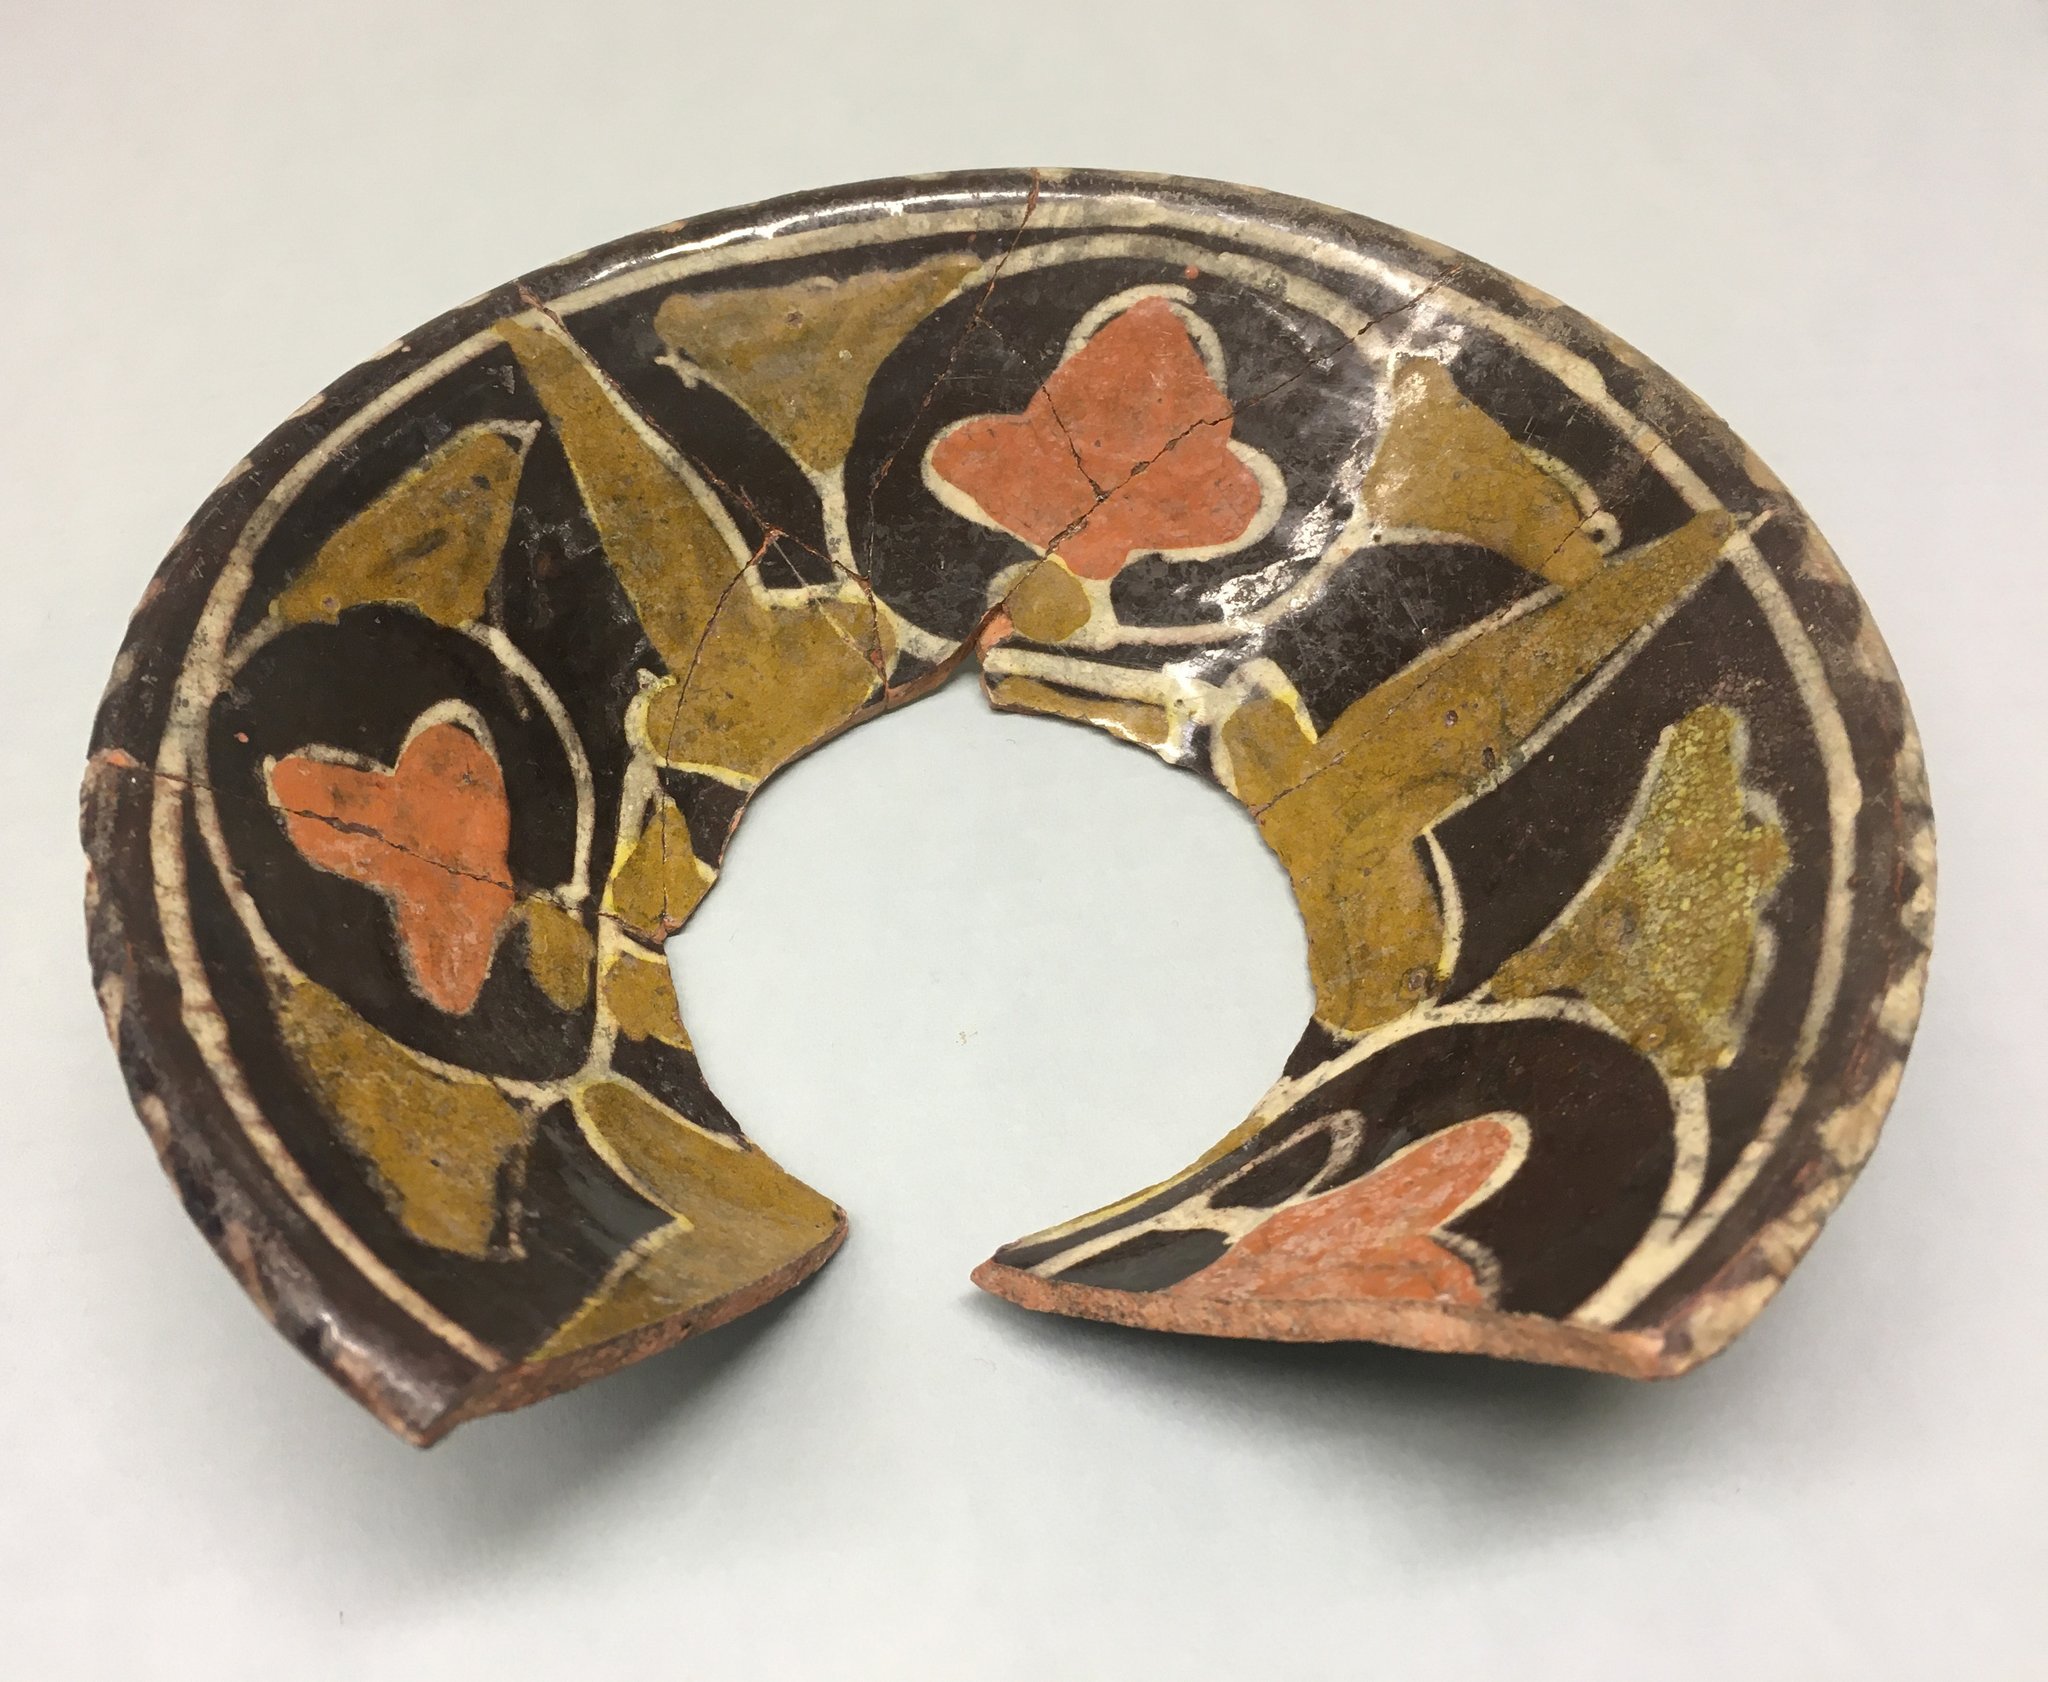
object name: bowl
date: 801-1000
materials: earthenware, glaze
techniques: painting, polychrome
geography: iran